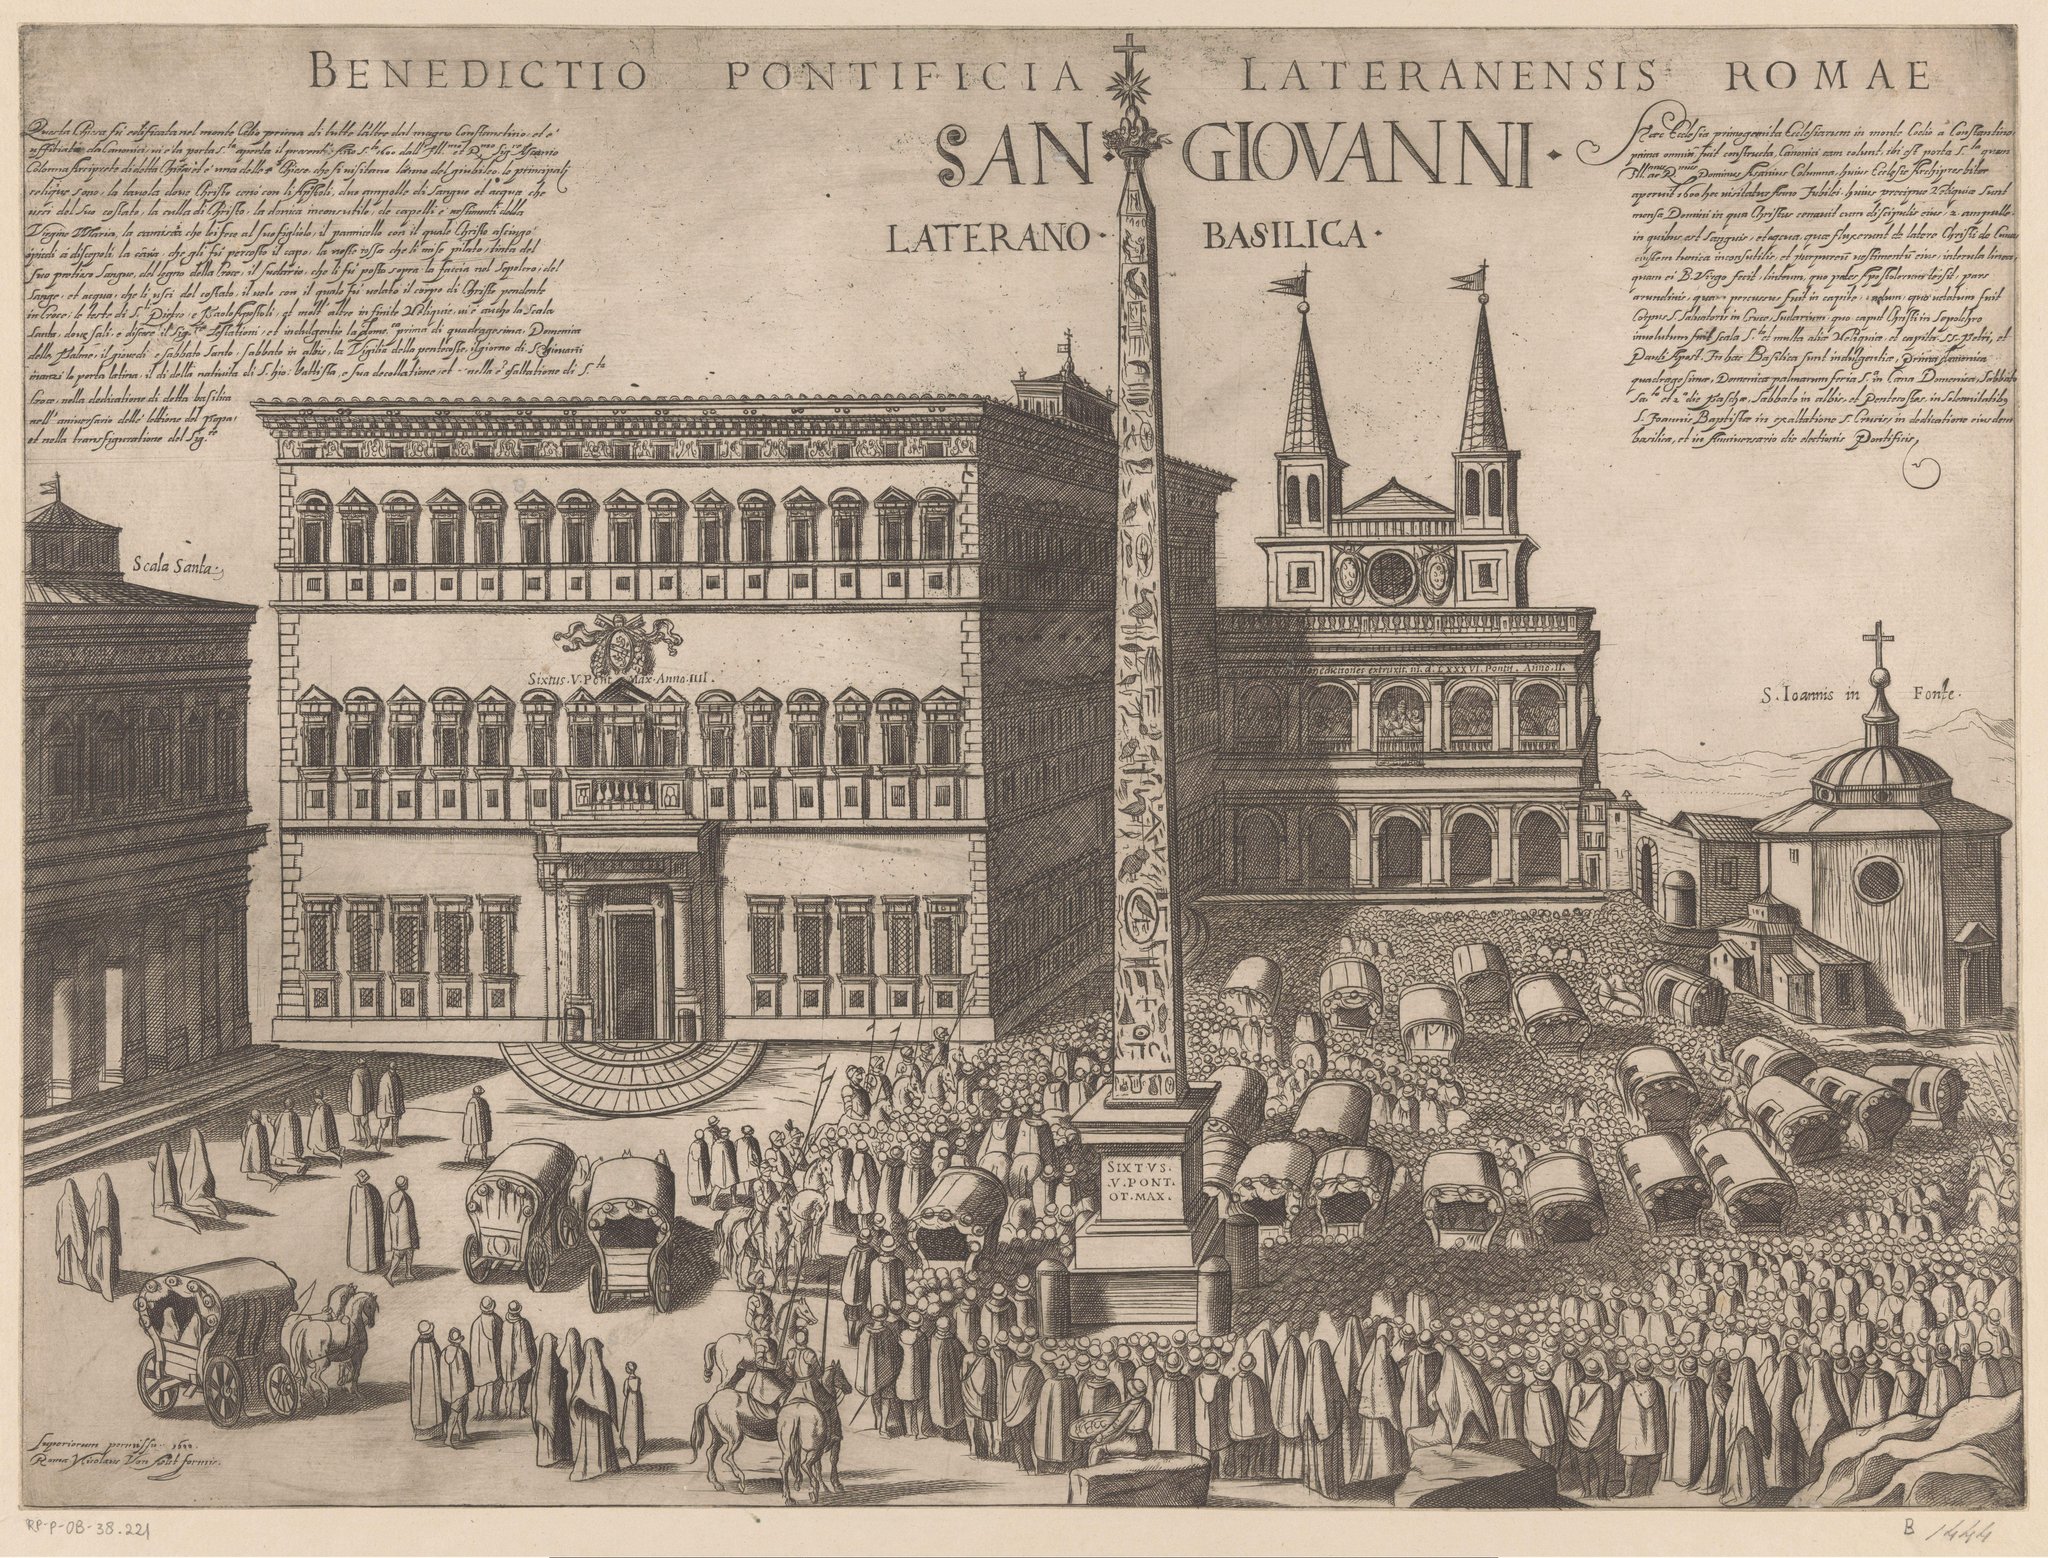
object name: print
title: De negen hoofdkerken van Rome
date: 1600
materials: paper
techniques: etching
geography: italy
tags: church (exterior), roman catholic church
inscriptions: collector's mark: Lugt 240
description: Gezicht op het Lateraan te Rome met de Heilige Trap (Scala Sancta), de achterzijde van de basiliek van Sint-Jan van Lateranen, het Lateraans Paleis, het Baptisterium van Lateranen en de Lateraanse Obelisk.